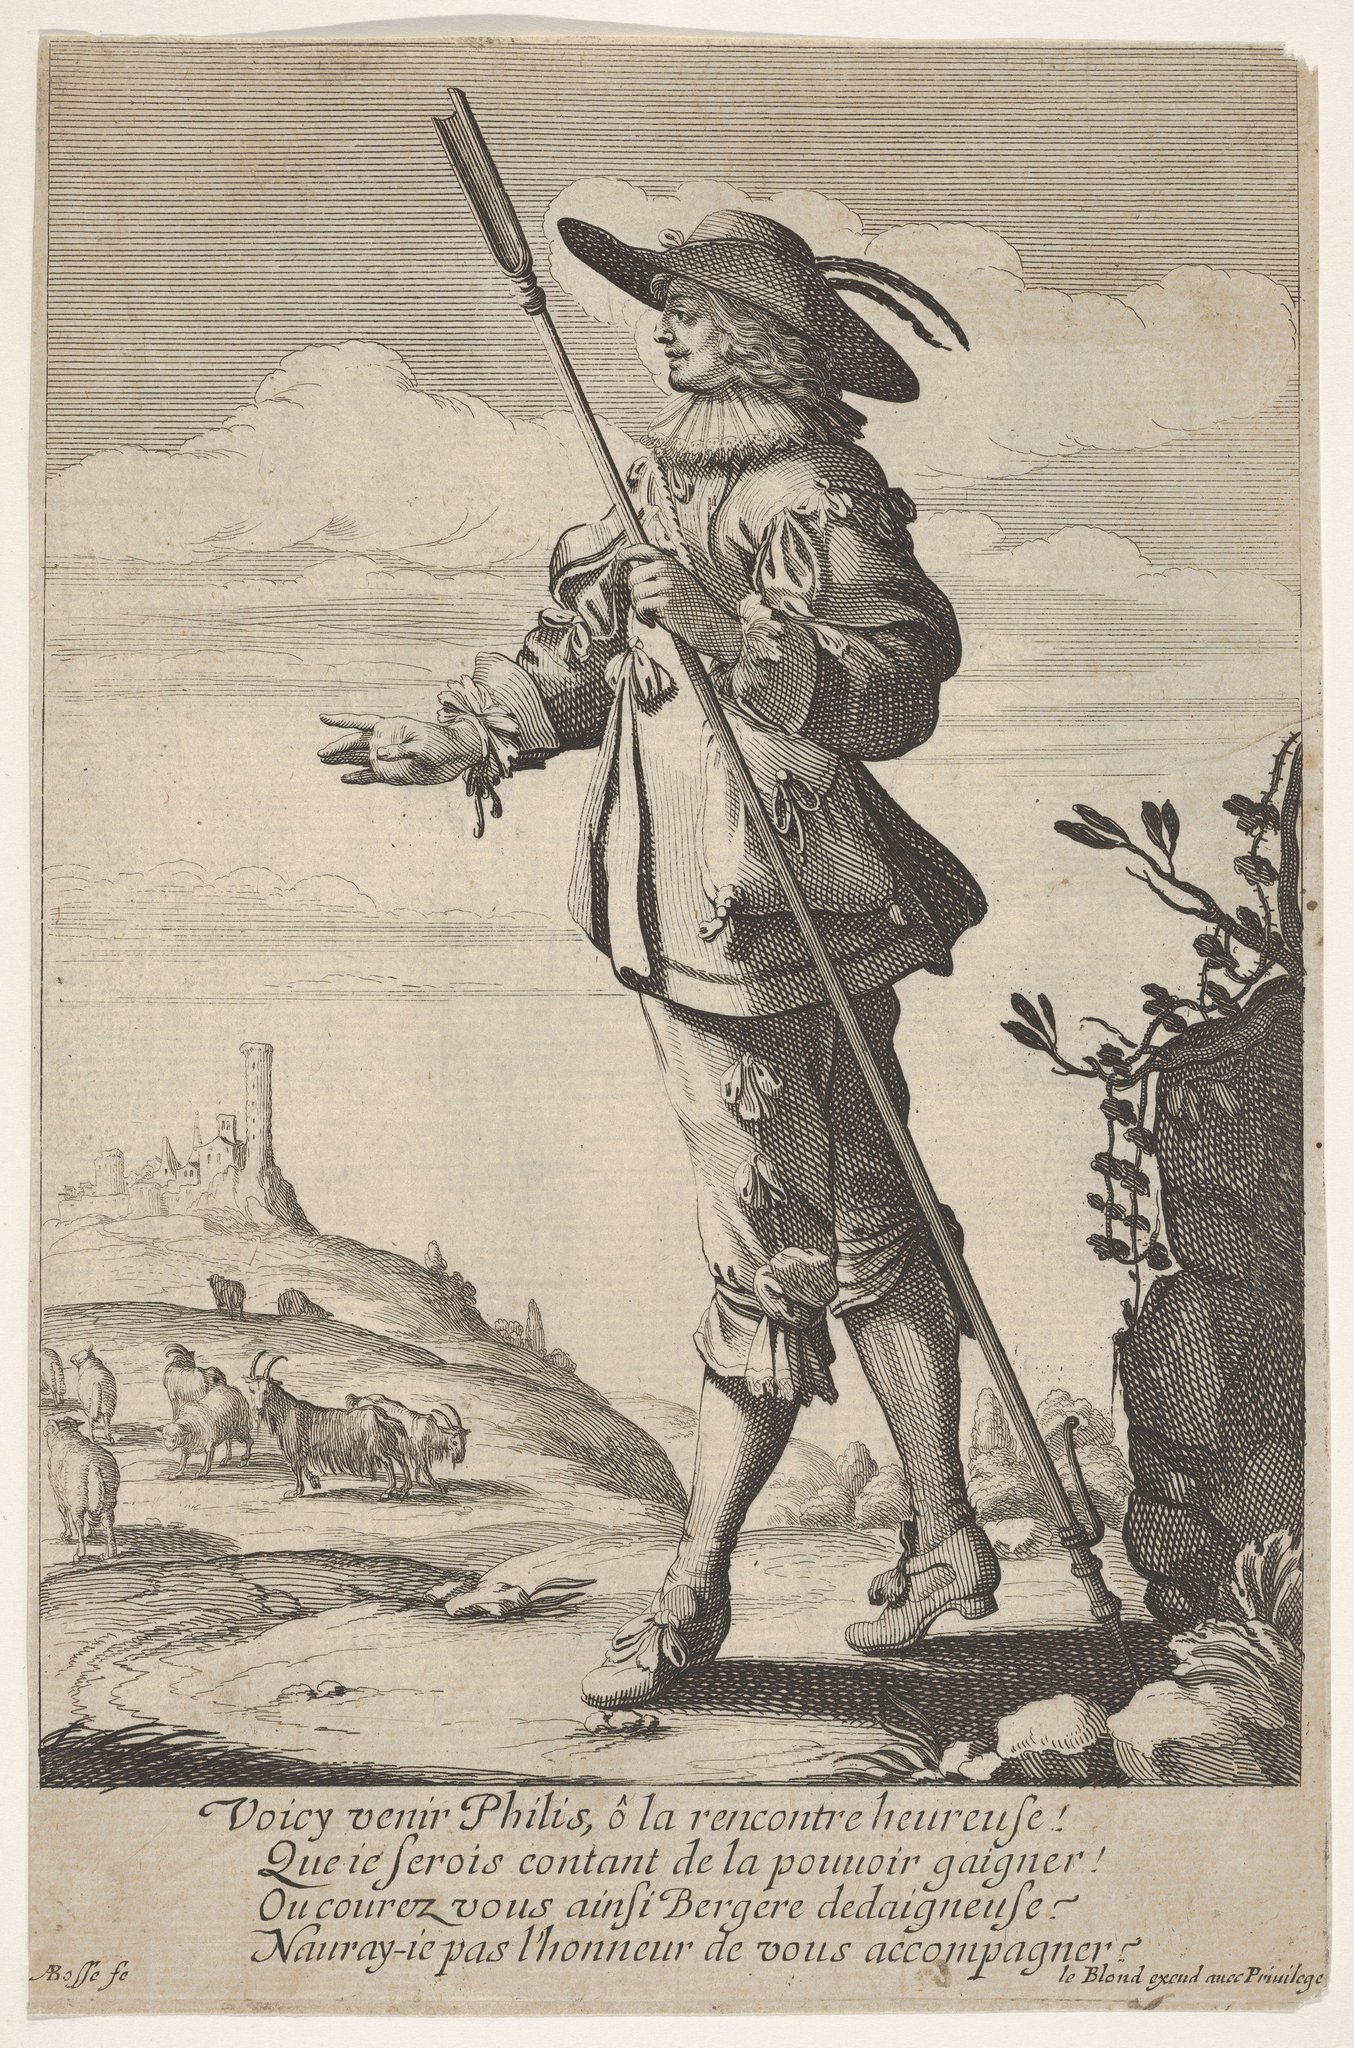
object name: print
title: A shepherd holding a crook in his left hand and walking with a hill, a town and goats in the distance at left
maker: abraham bosse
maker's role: artist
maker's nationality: french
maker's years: 1602-1676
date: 1640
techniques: etching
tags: goats,shepherds